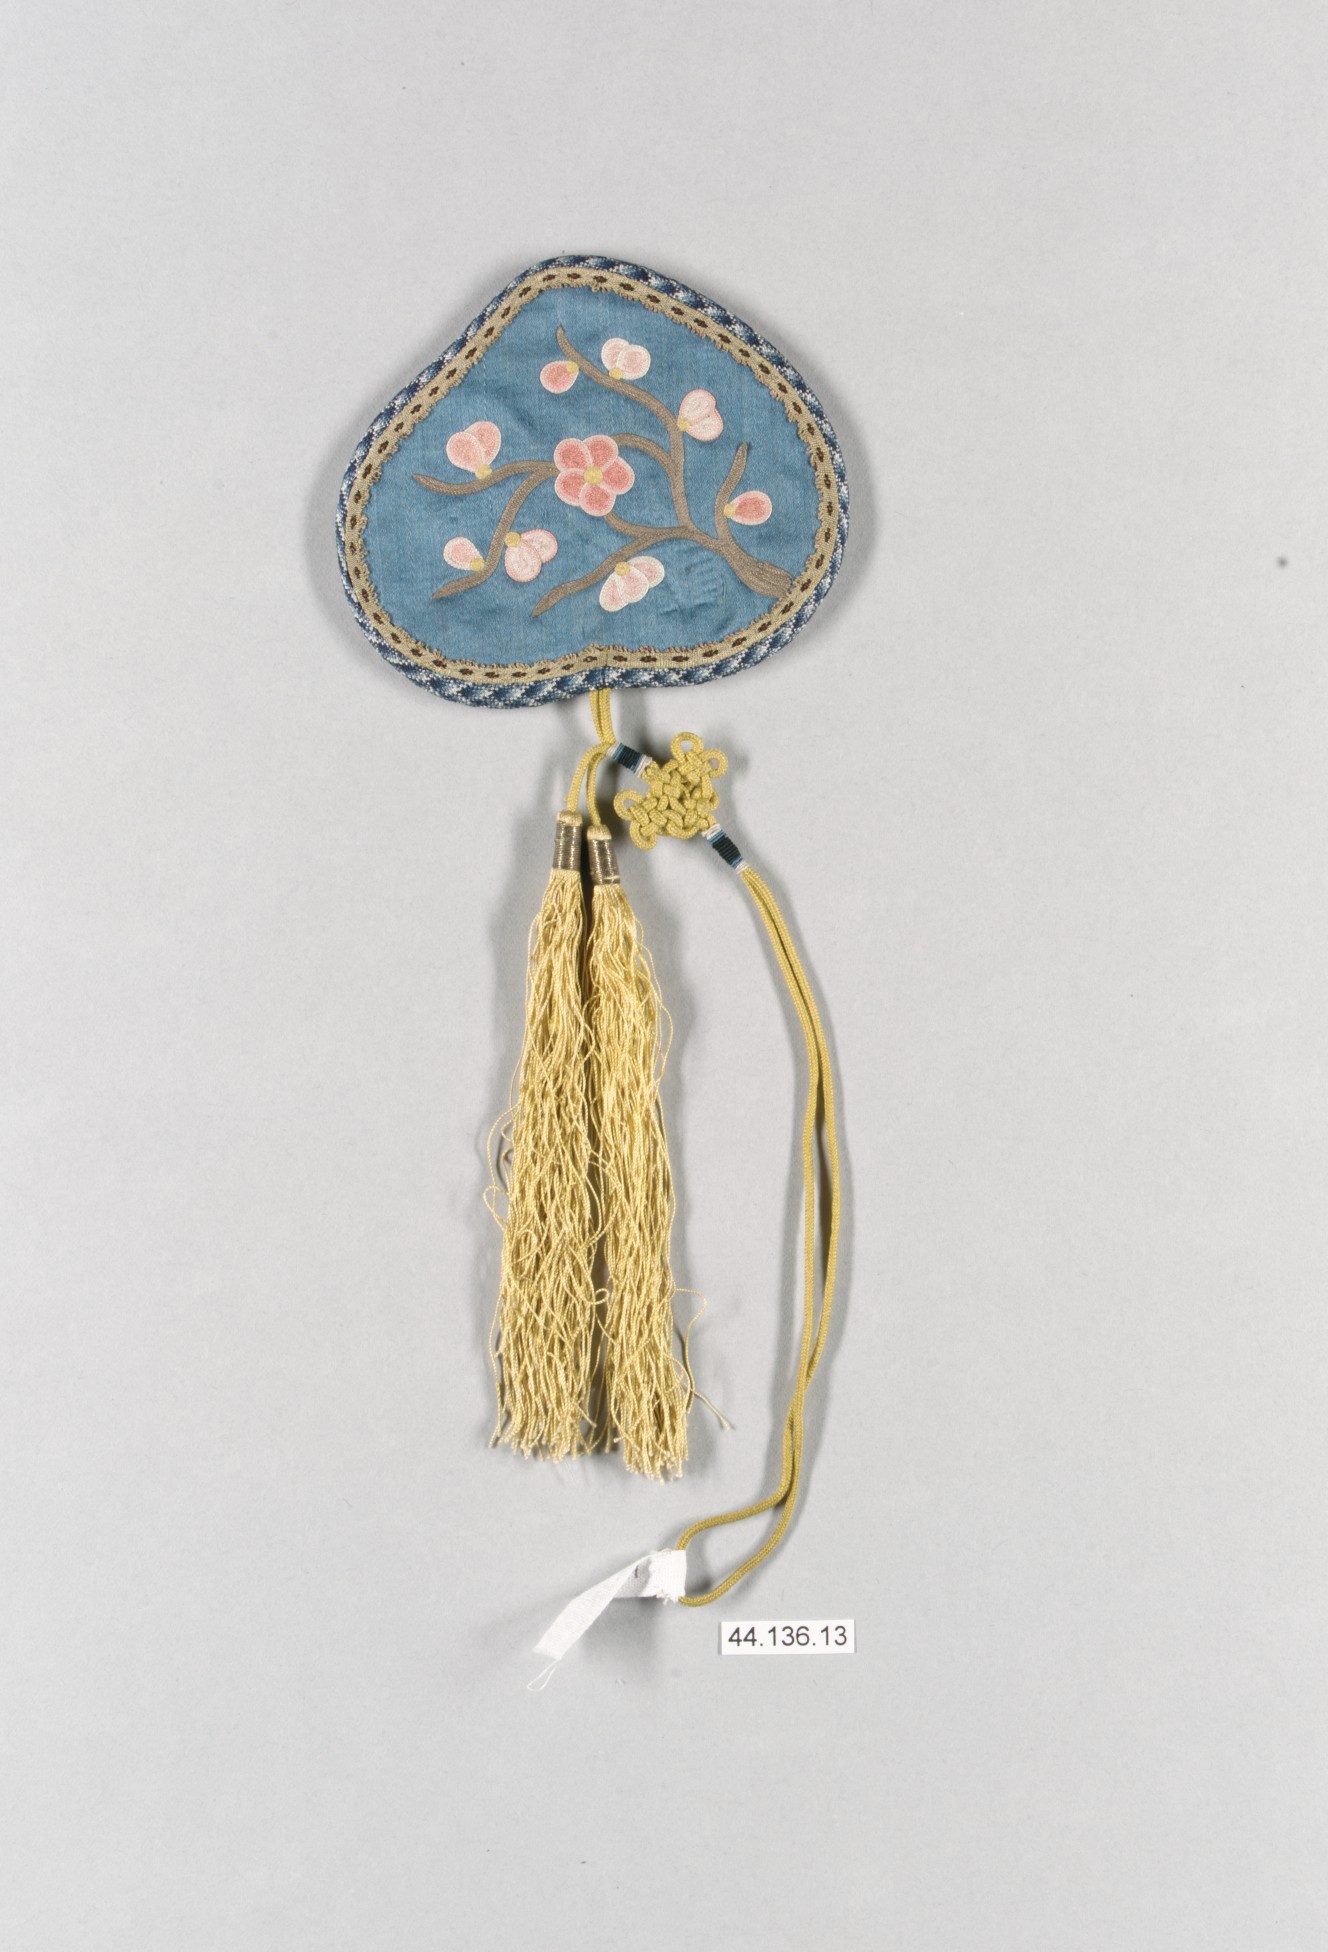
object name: mirror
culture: chinese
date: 1801-1900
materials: glass, silk